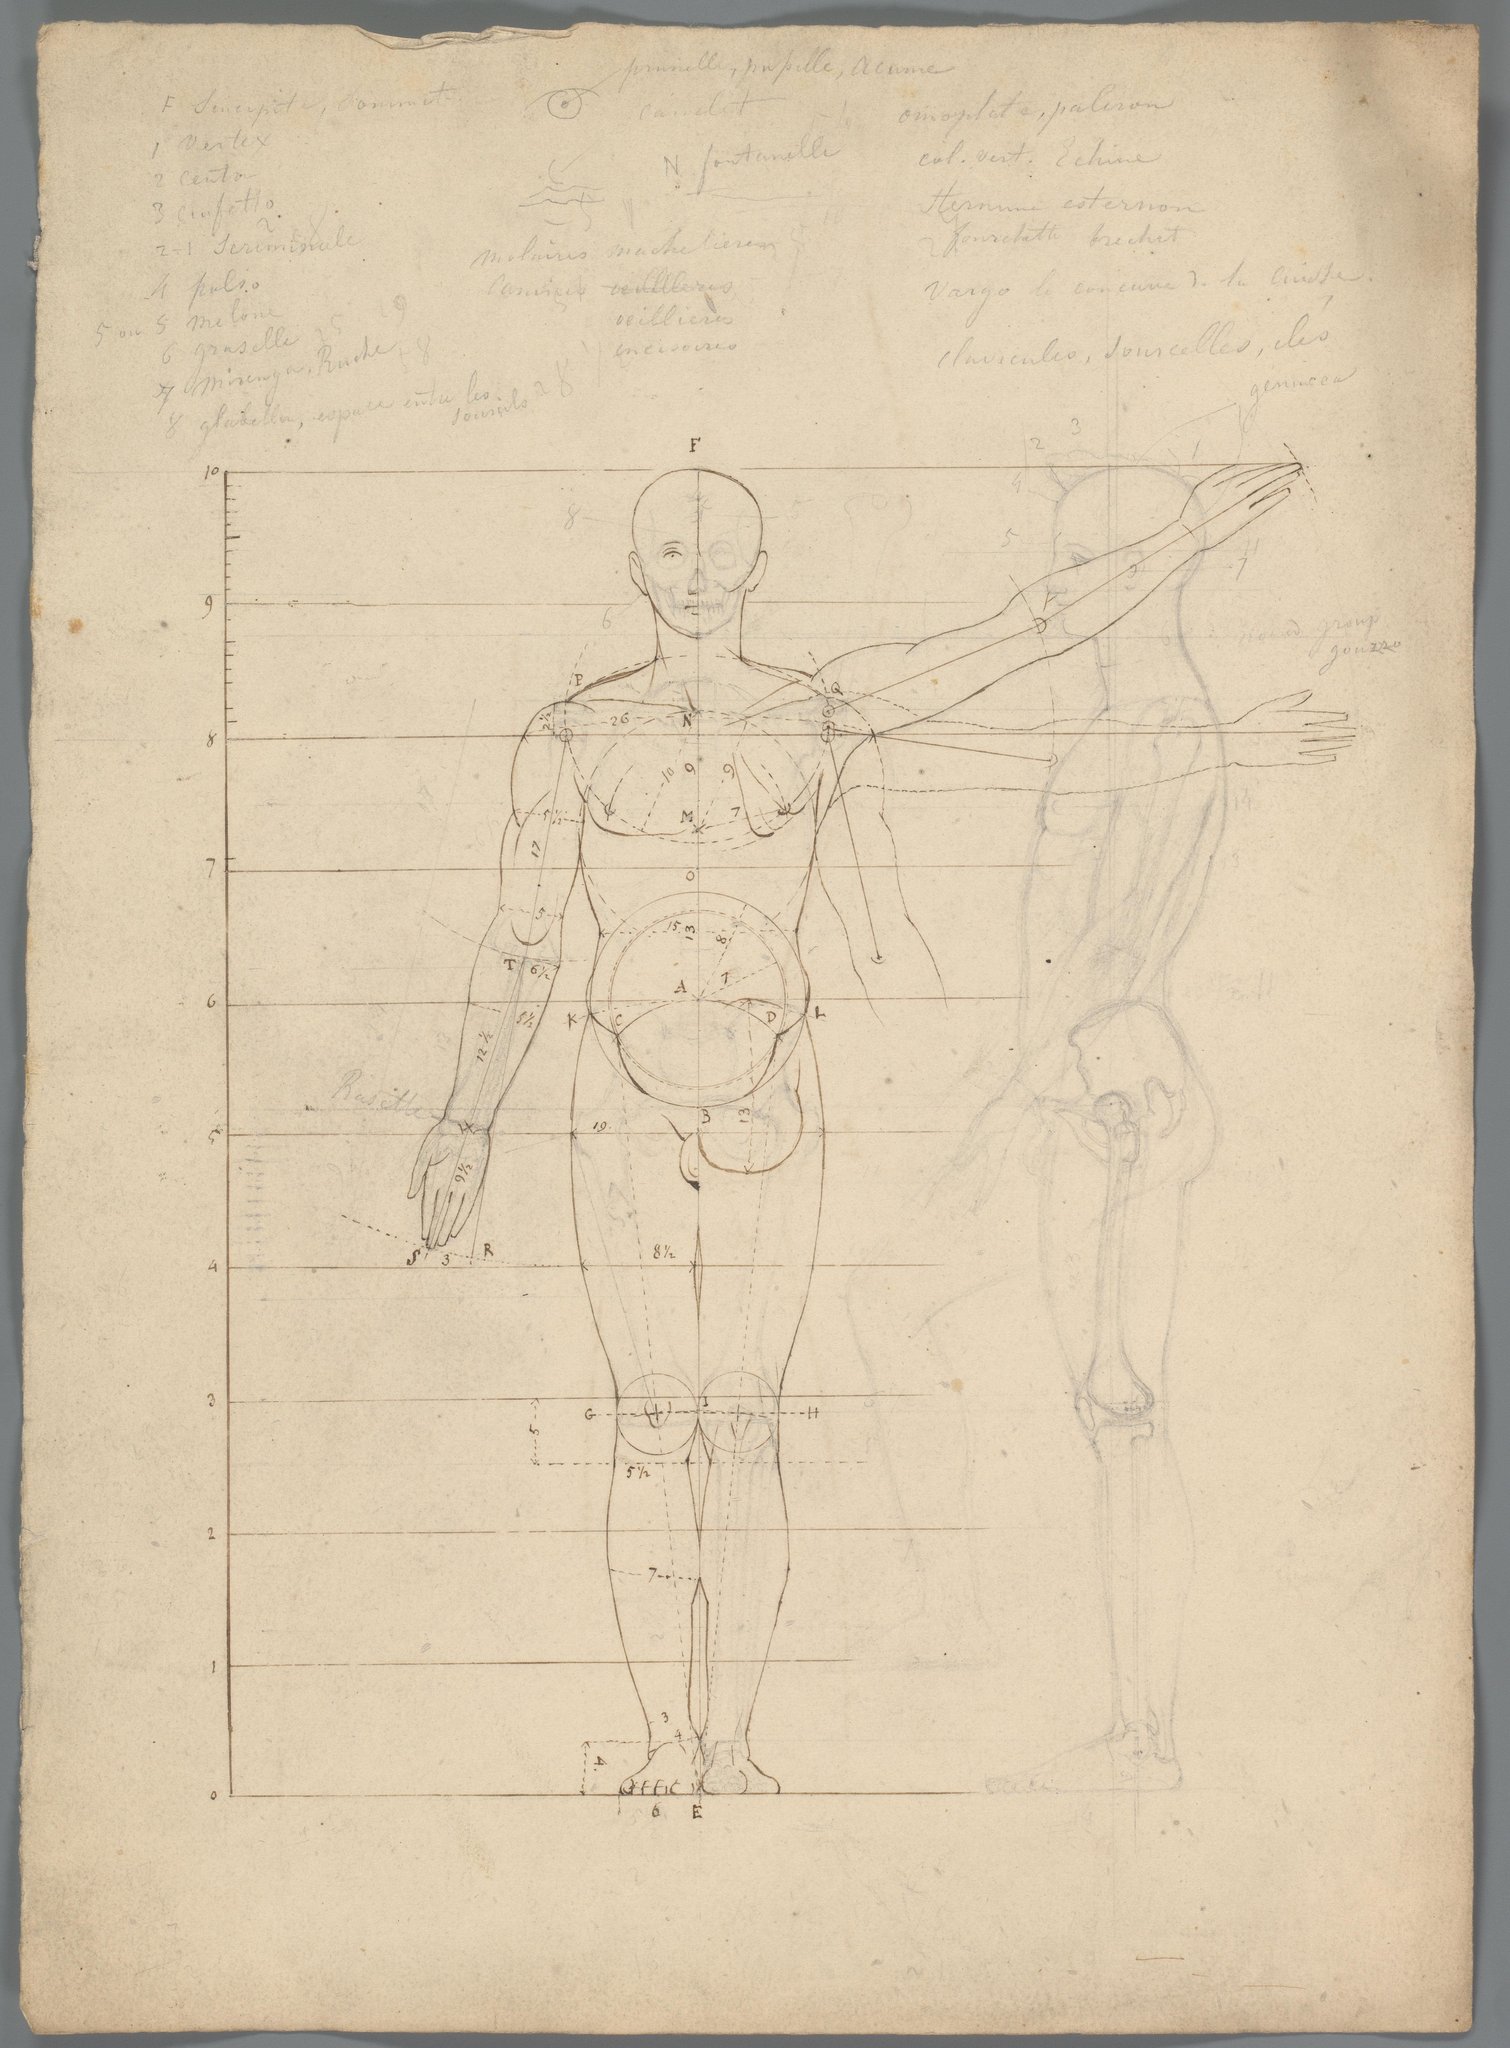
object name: drawing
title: Proportiestudie van een man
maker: jacobus everhardus josephus van den berg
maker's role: draughtsman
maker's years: 1802-1861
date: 1812-1861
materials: ink, paper, pencil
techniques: pen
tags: human figure of ideal proportions, e.g. academic nude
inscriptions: inscription